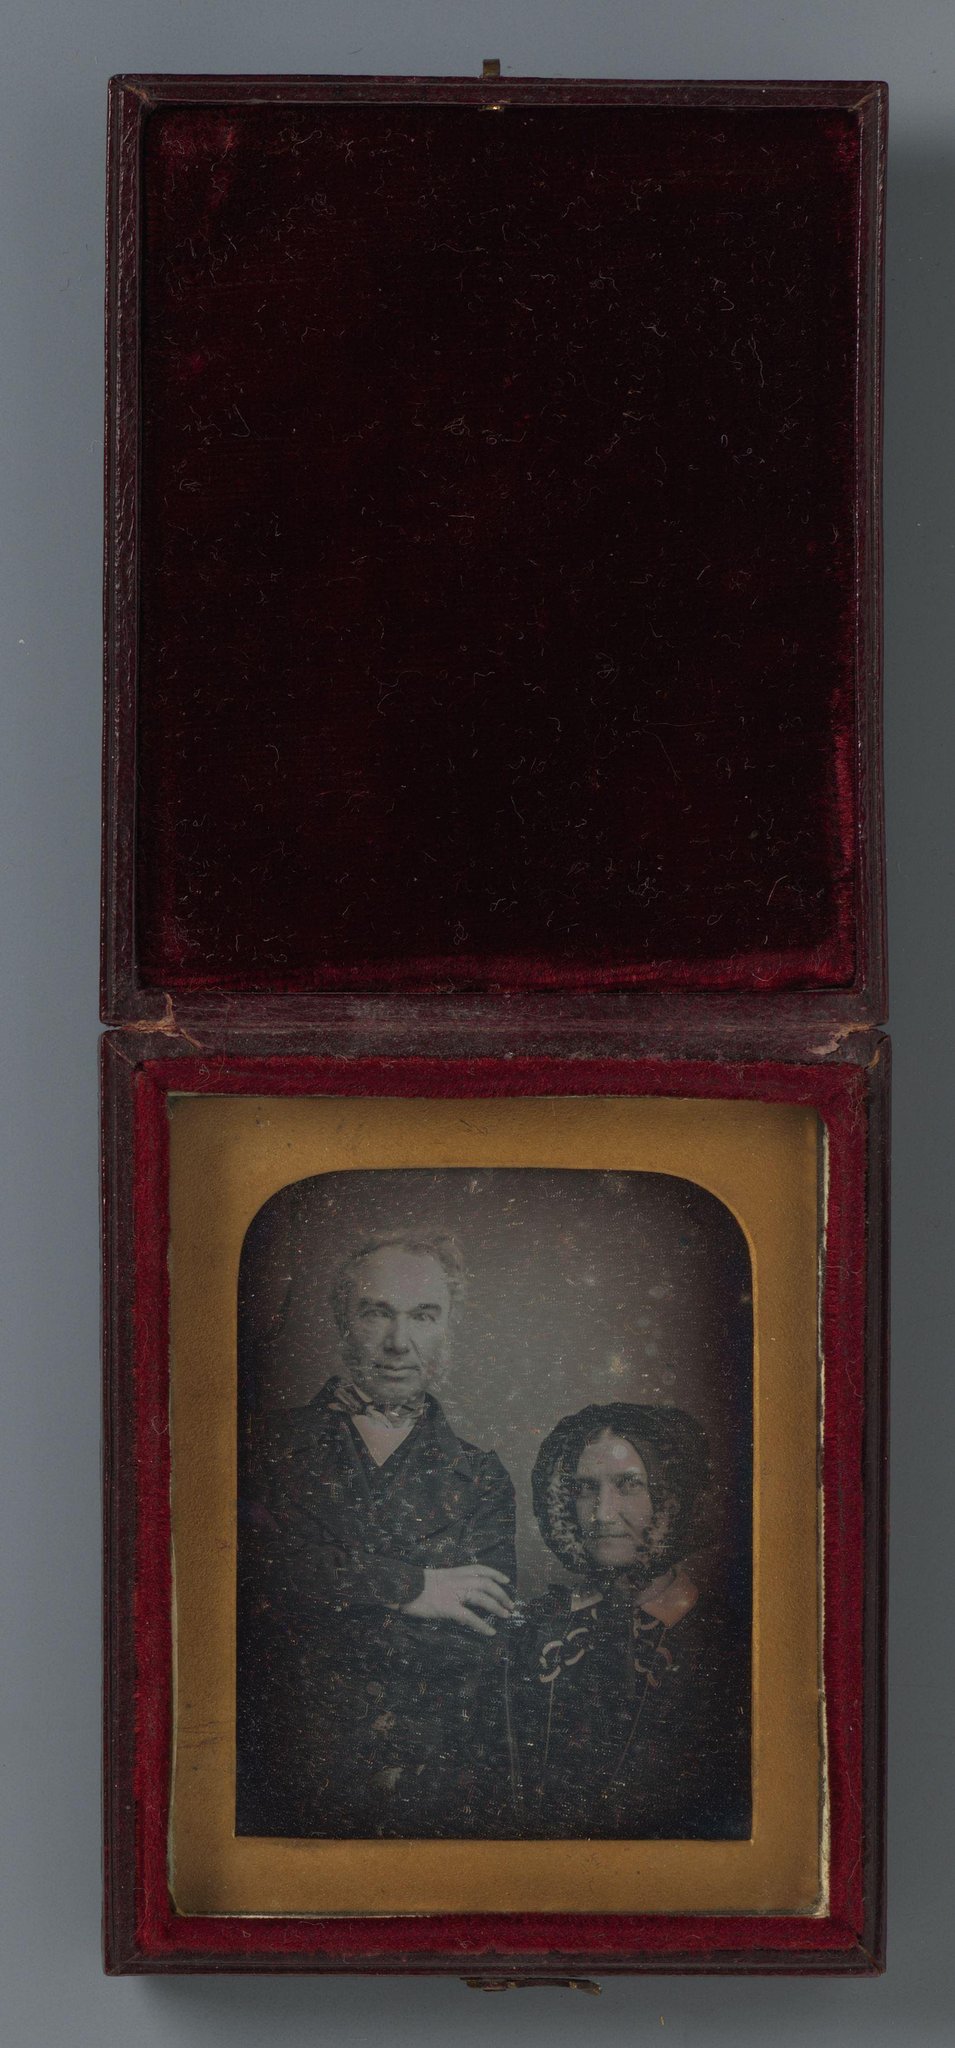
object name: photograph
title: Portret van een onbekend echtpaar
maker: Anonymous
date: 1840-1860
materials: copper, glass, leather, velvet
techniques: daguerreotype